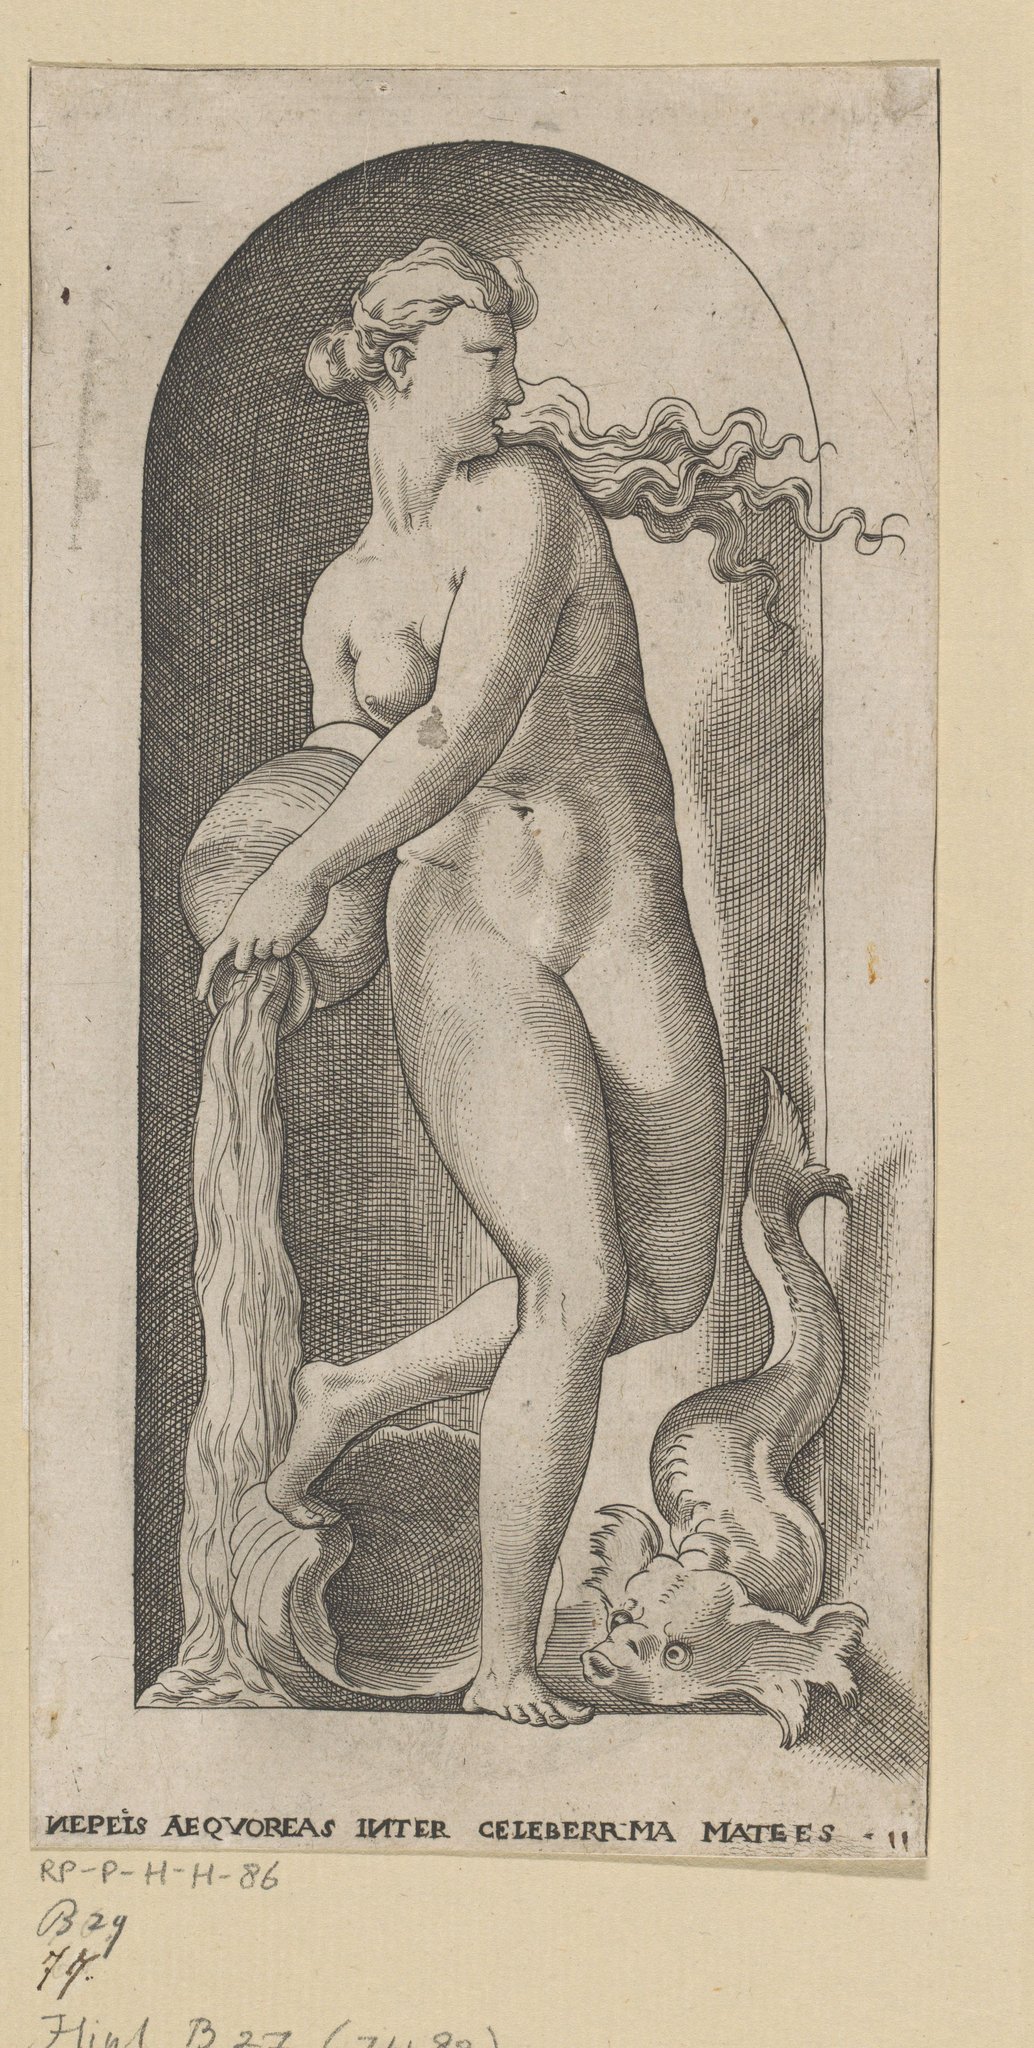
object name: print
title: Nepeis aequoreas inter celeberrma mate es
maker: jacob binck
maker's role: painter, print maker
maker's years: 1494-1569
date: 1510-1569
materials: paper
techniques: engraving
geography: italy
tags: (story of) thetis; 'thethi, ninfa del mare' (ripa)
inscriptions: number: ‘11’, collector's mark: Lugt 11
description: De godin Thetis staat met een kruik met water, een schelp en een vis in een nis.